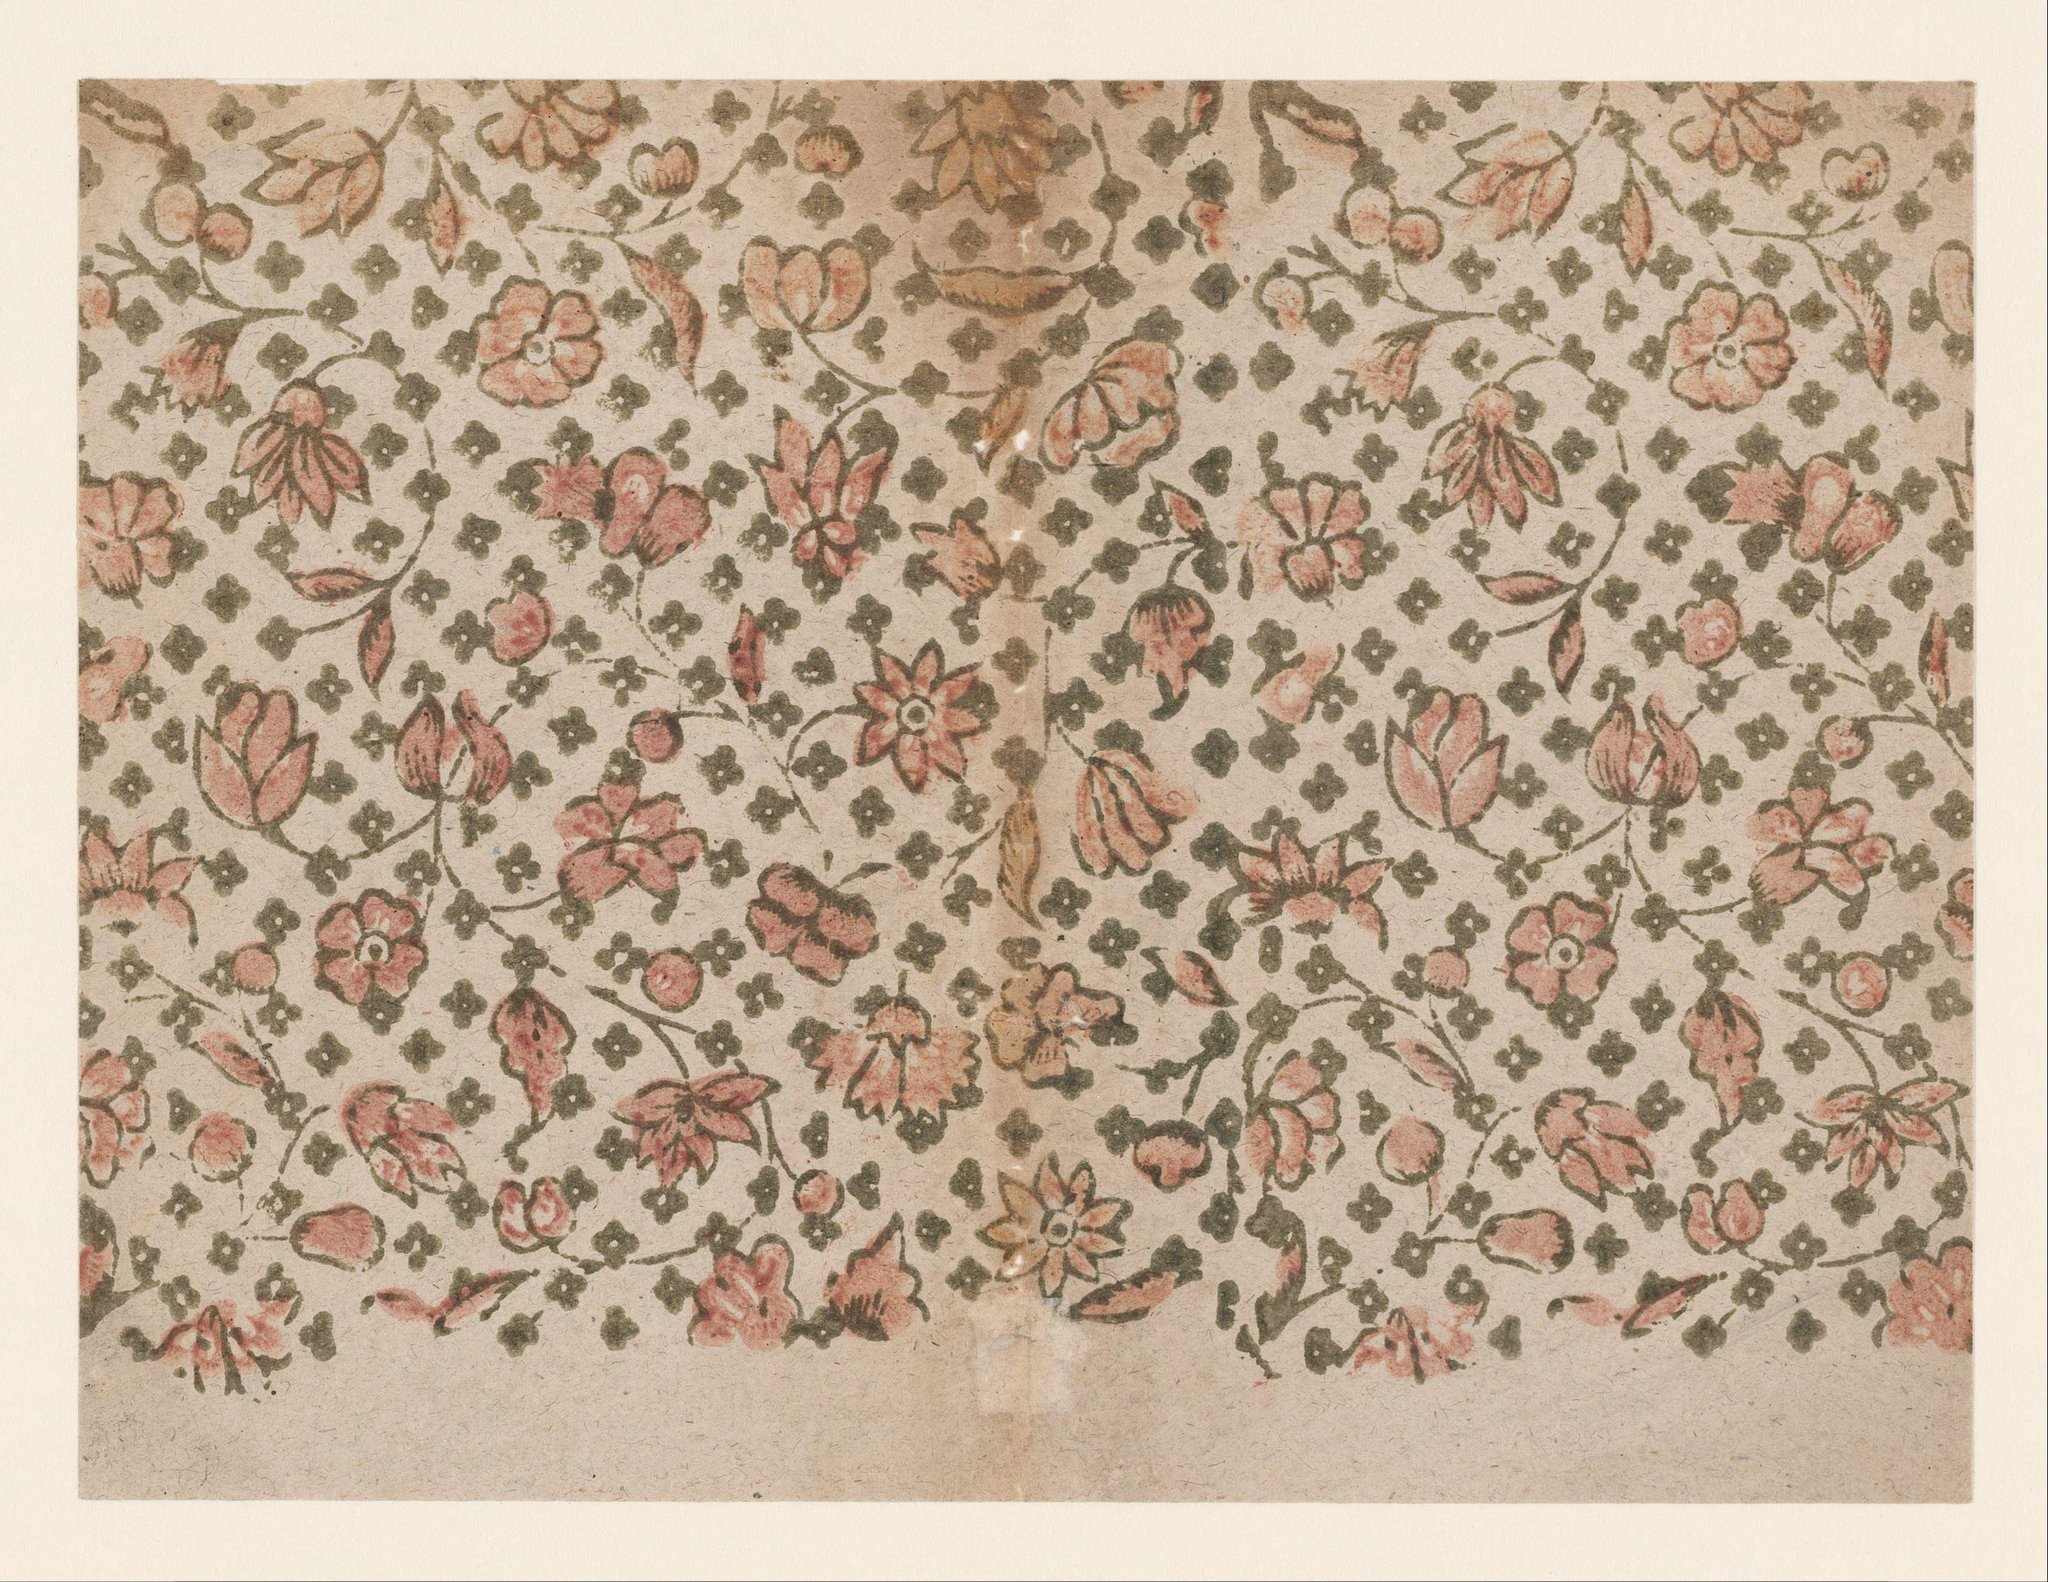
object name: printed paper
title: Blad met strooipatroon van bloemen over een strooipatroon van blaadjes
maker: Anonymous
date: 1700-1850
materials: paper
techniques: printing block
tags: ornament derived from plant forms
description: Blad met strooipatroon van bloemen over een strooipatroon van blaadjes. Gebruikt als omslag.